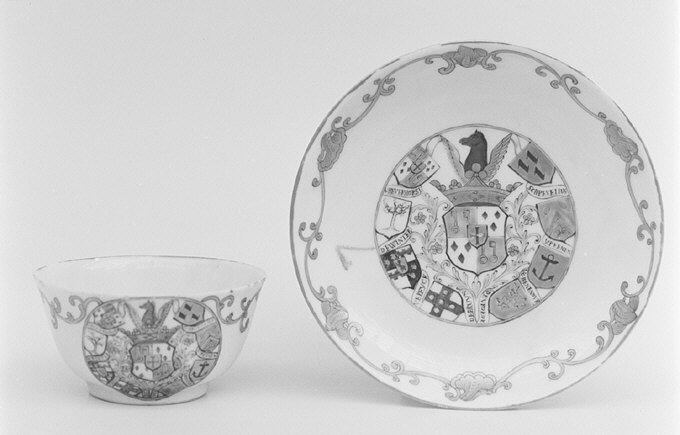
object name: teabowl and saucer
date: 1750-1760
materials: hard paste porcelain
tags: coat of arms